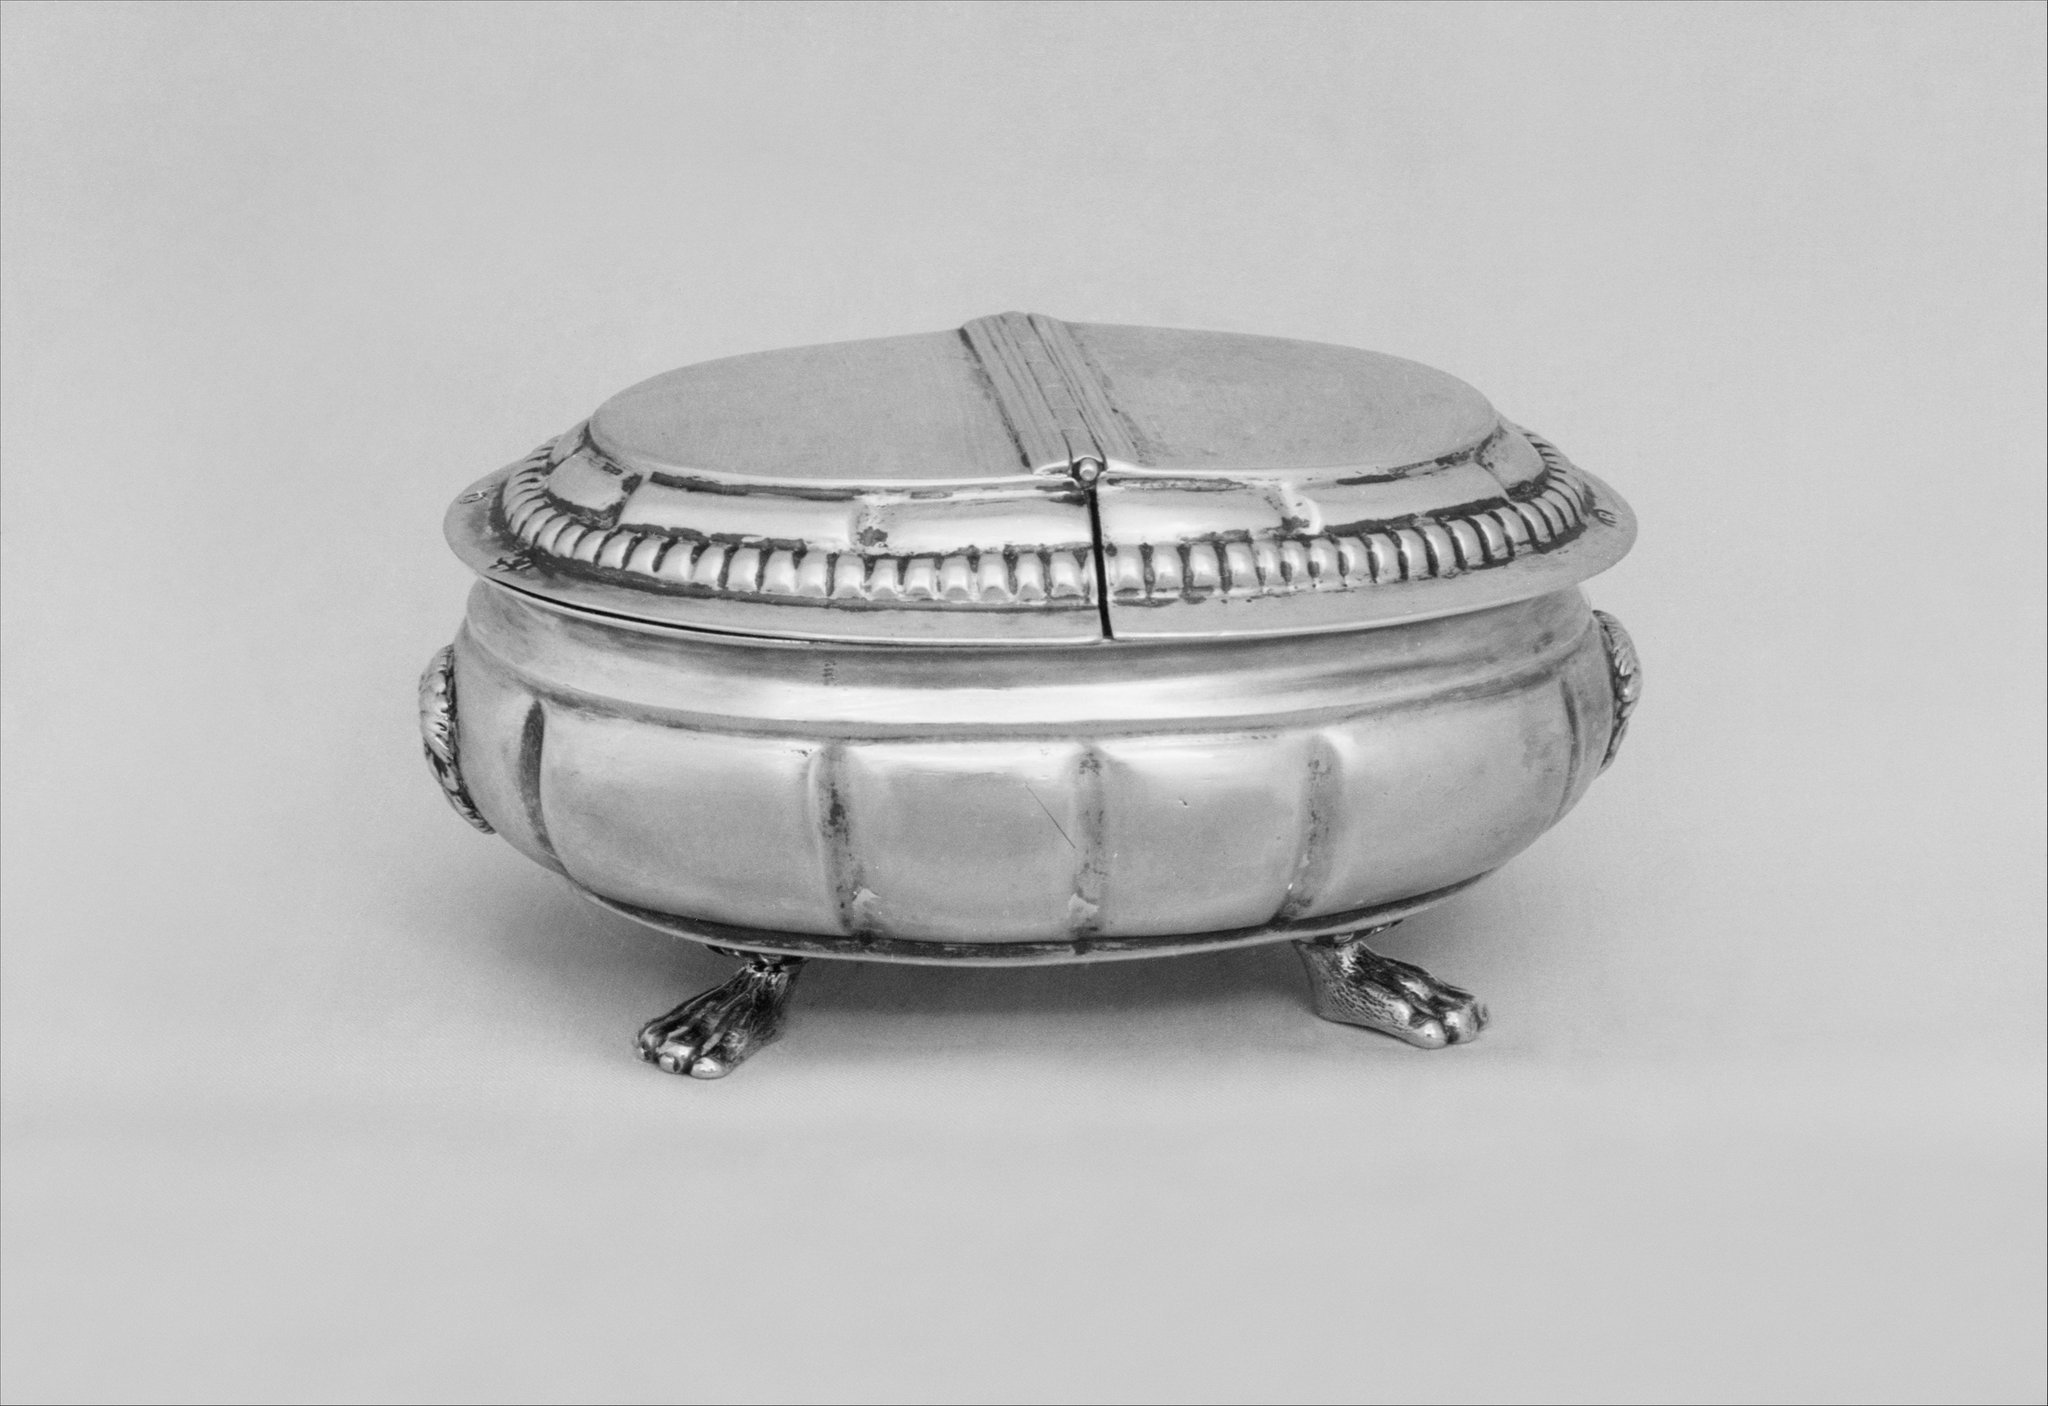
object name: spice box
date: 1701-1750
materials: silver